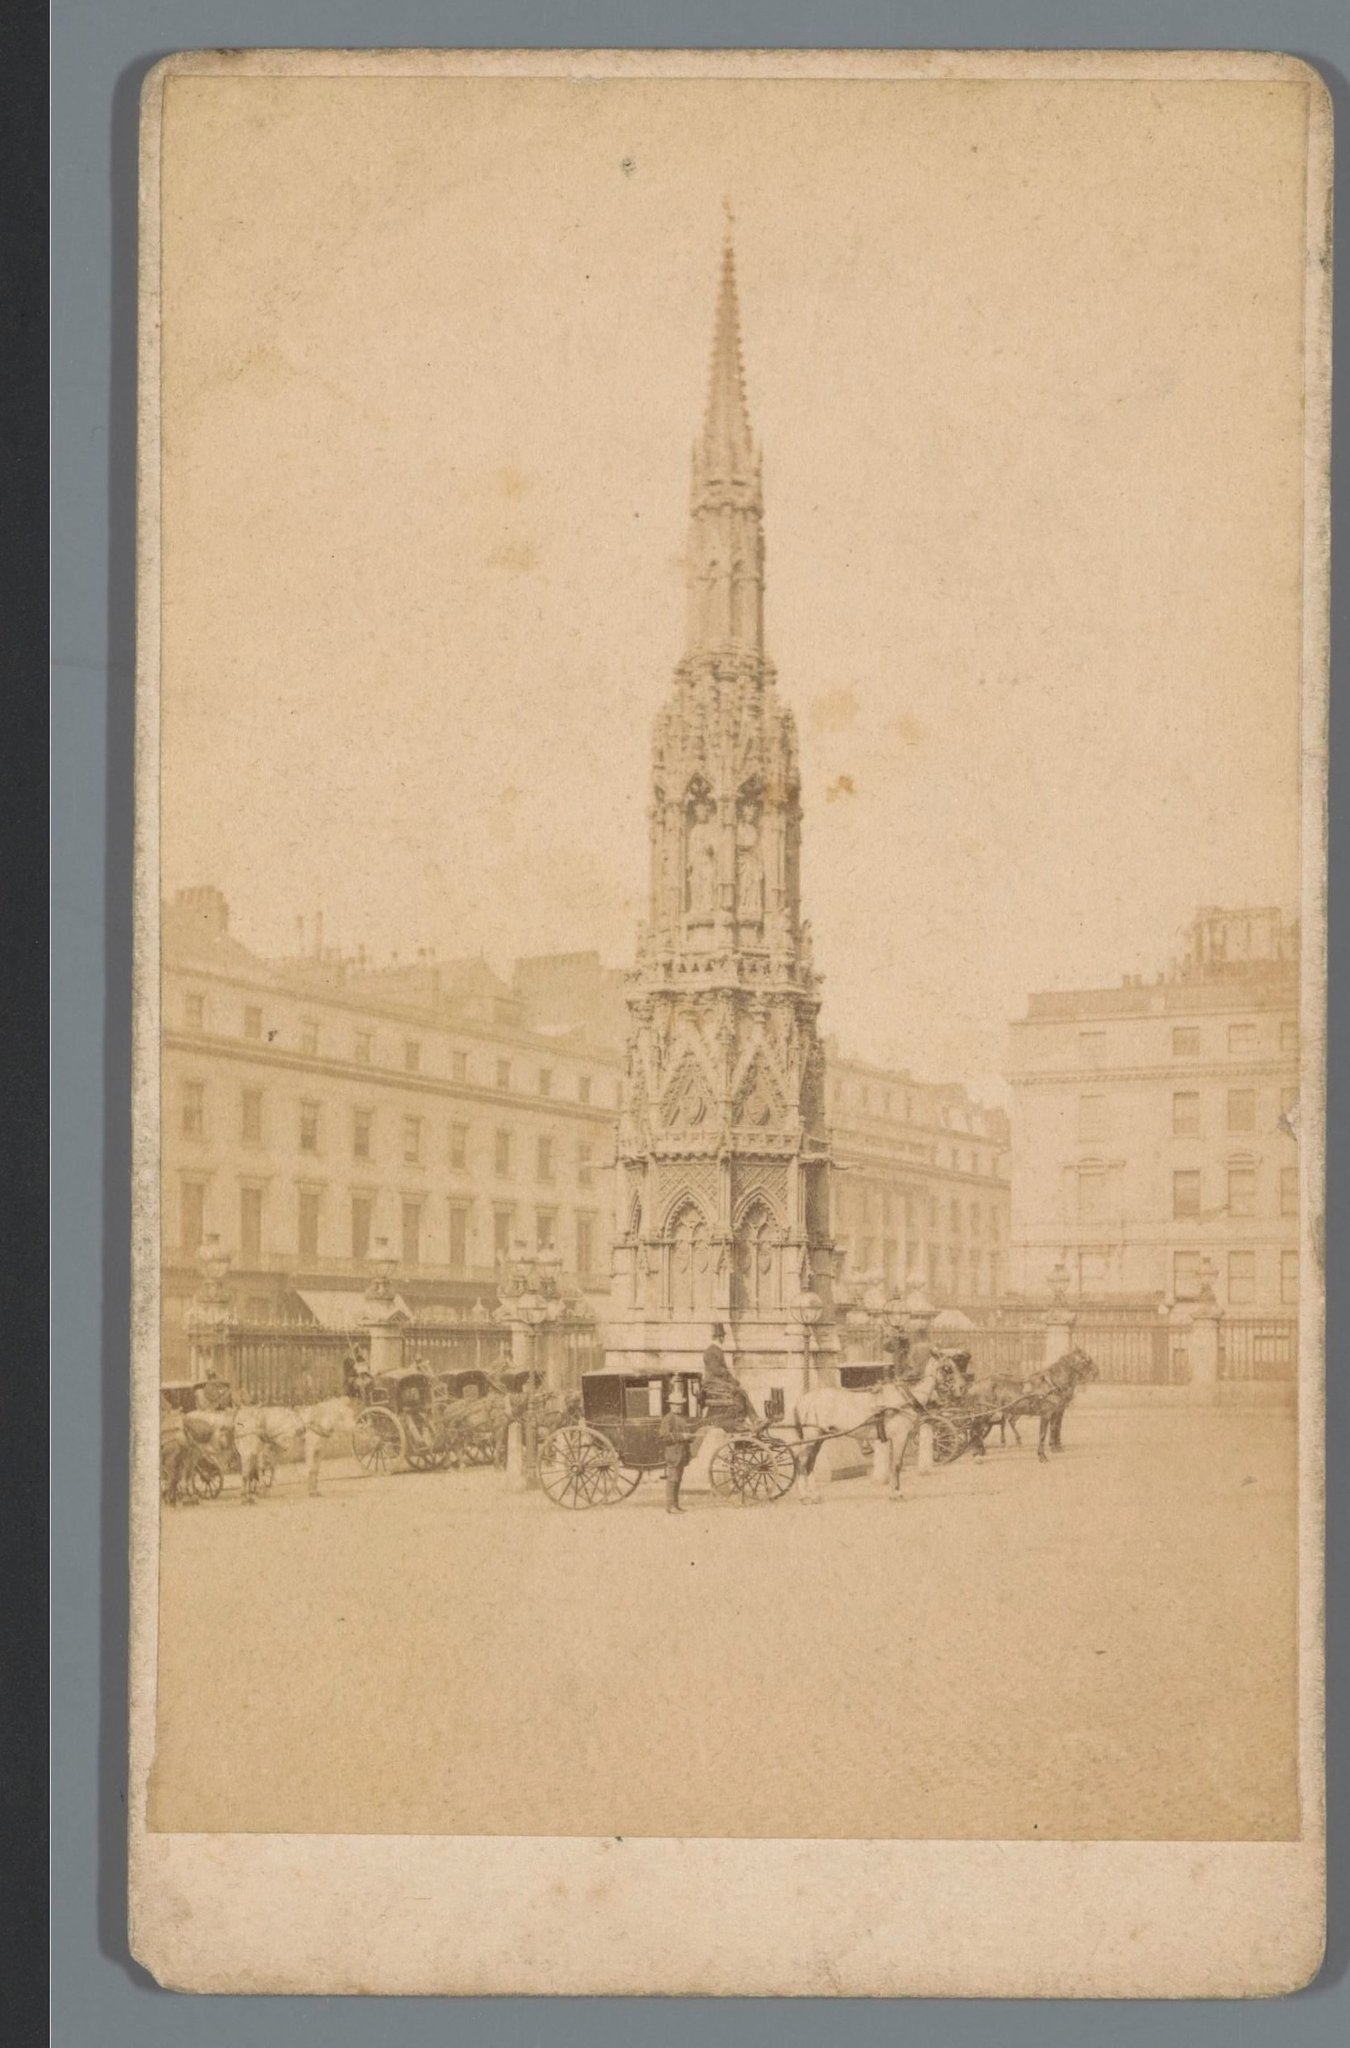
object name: photograph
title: Charing Cross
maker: Anonymous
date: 1865-1870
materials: cardboard, paper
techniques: albumen print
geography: london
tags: monument, statue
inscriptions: address: ‘Published by/ Dalton and Lucy/ Booksellers to the Queen,/ 28, Cockspur Street, S.W.’, number: ‘24.’